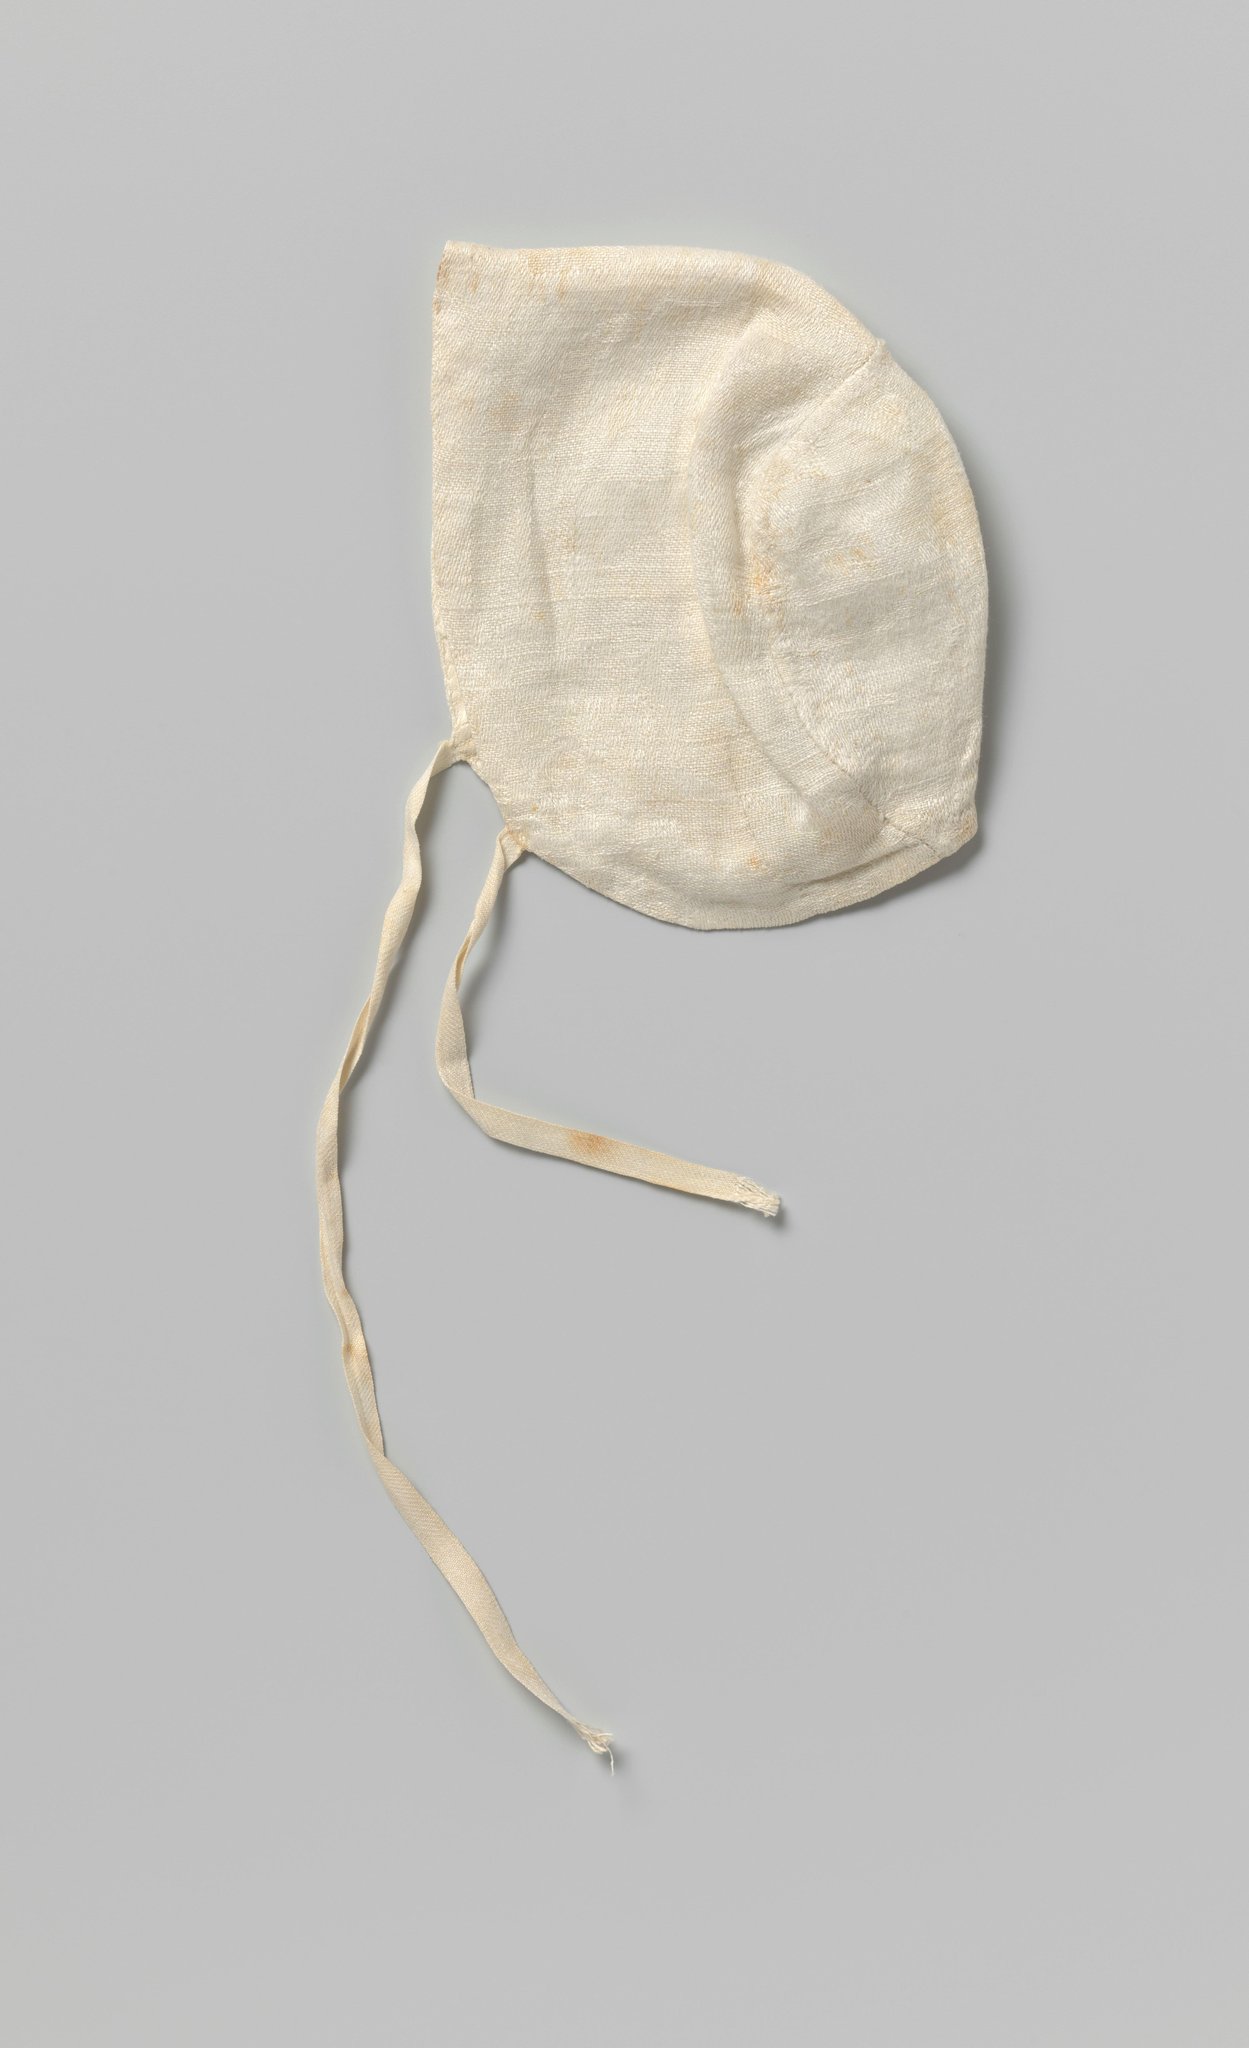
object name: cap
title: Kindermuts van wit damast met brede rand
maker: Anonymous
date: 1685-1715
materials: cotton, linen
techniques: damask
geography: netherlands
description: Een damasten babymutsje met een hoefijzervormige bol, waaraan een brede rand. De rand is gevoerd met een brede strook linnen. Sluiting door middel van twee katoenen bandjes. Gemerkt.